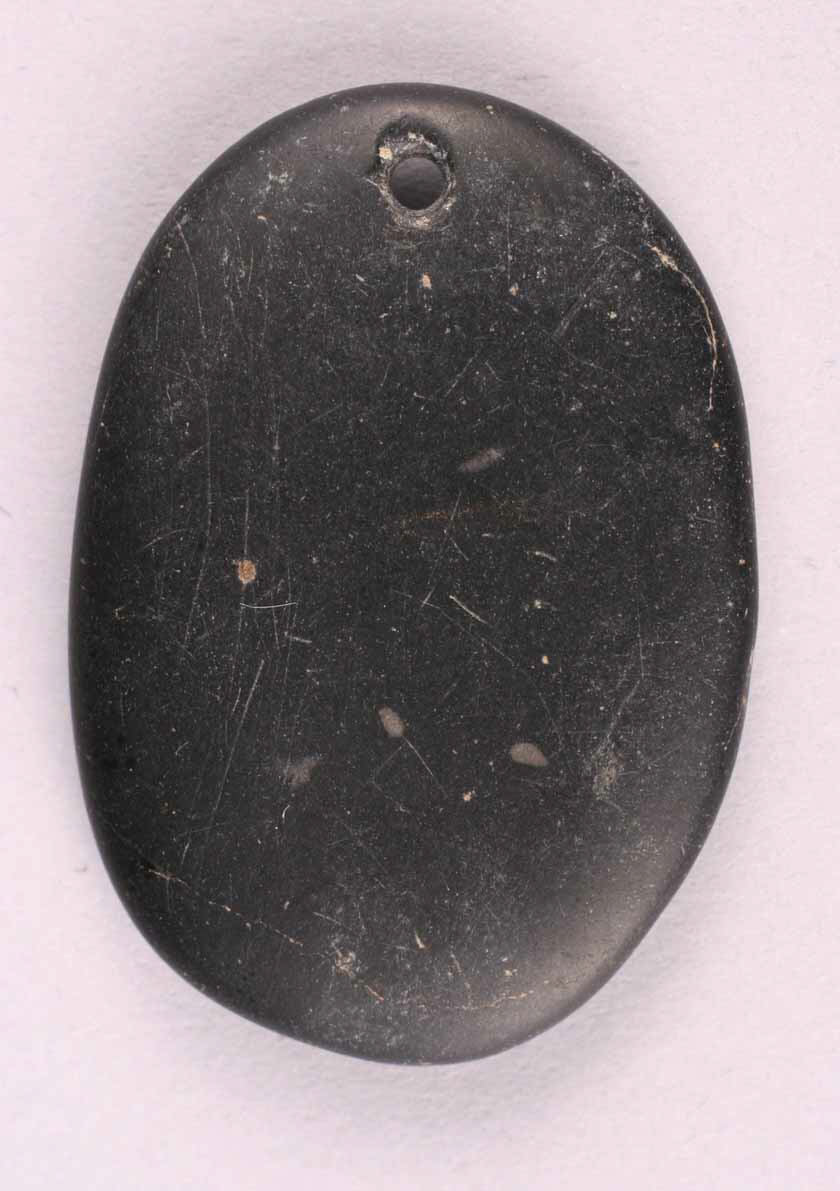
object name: pendant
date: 701-1300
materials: stone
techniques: carving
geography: iran